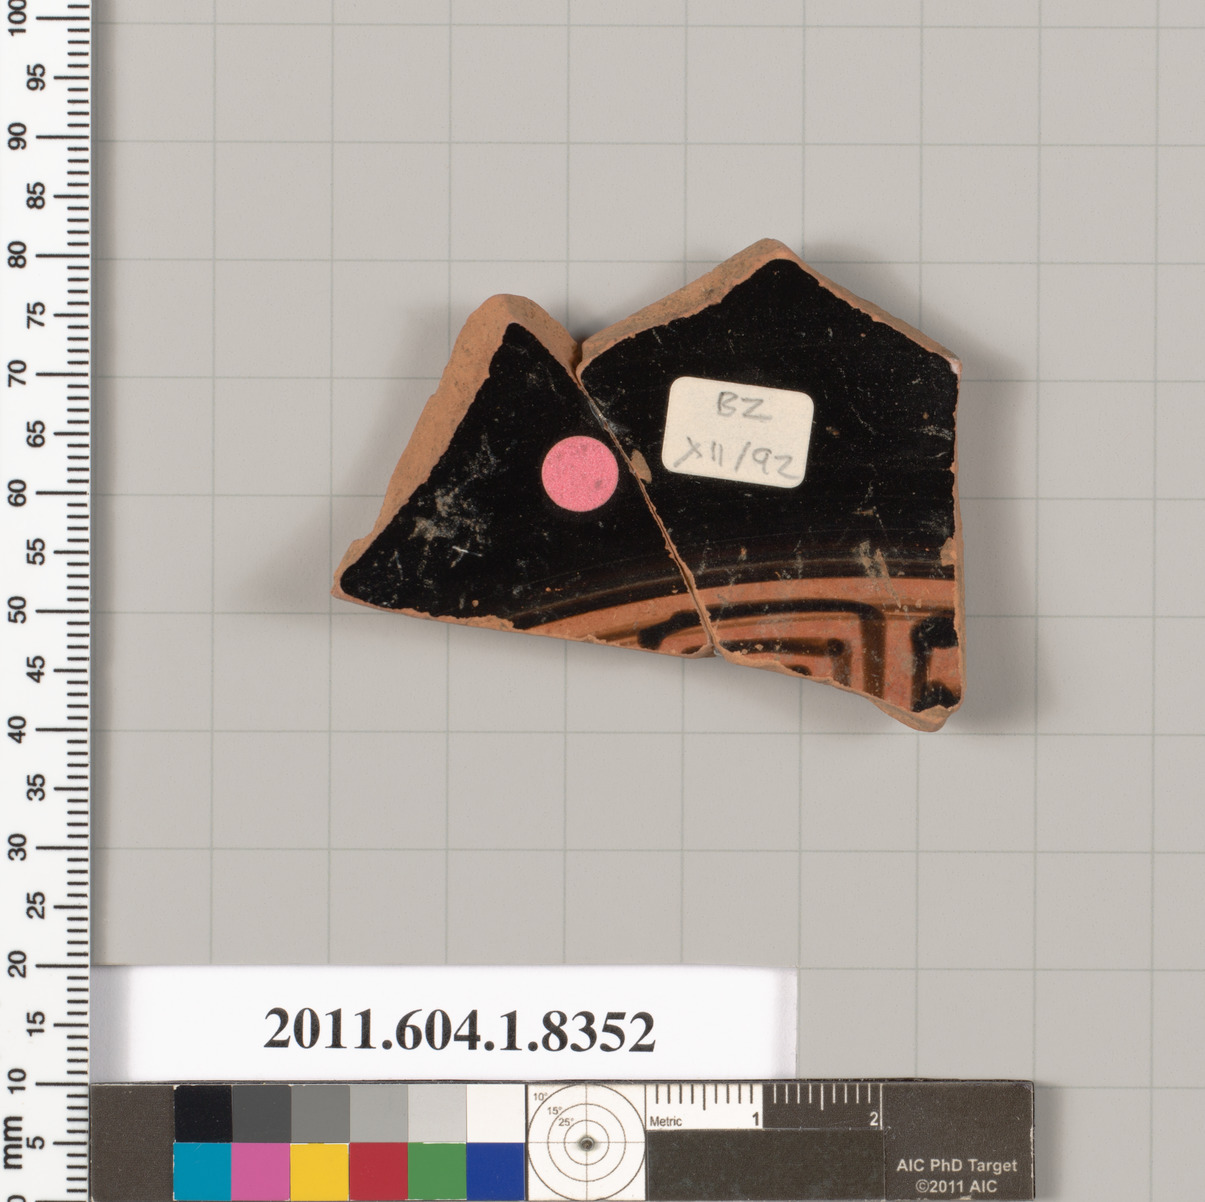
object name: kylix fragment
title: Terracotta fragment of a kylix (drinking cup)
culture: greek, attic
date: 434-368 BCE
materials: terracotta